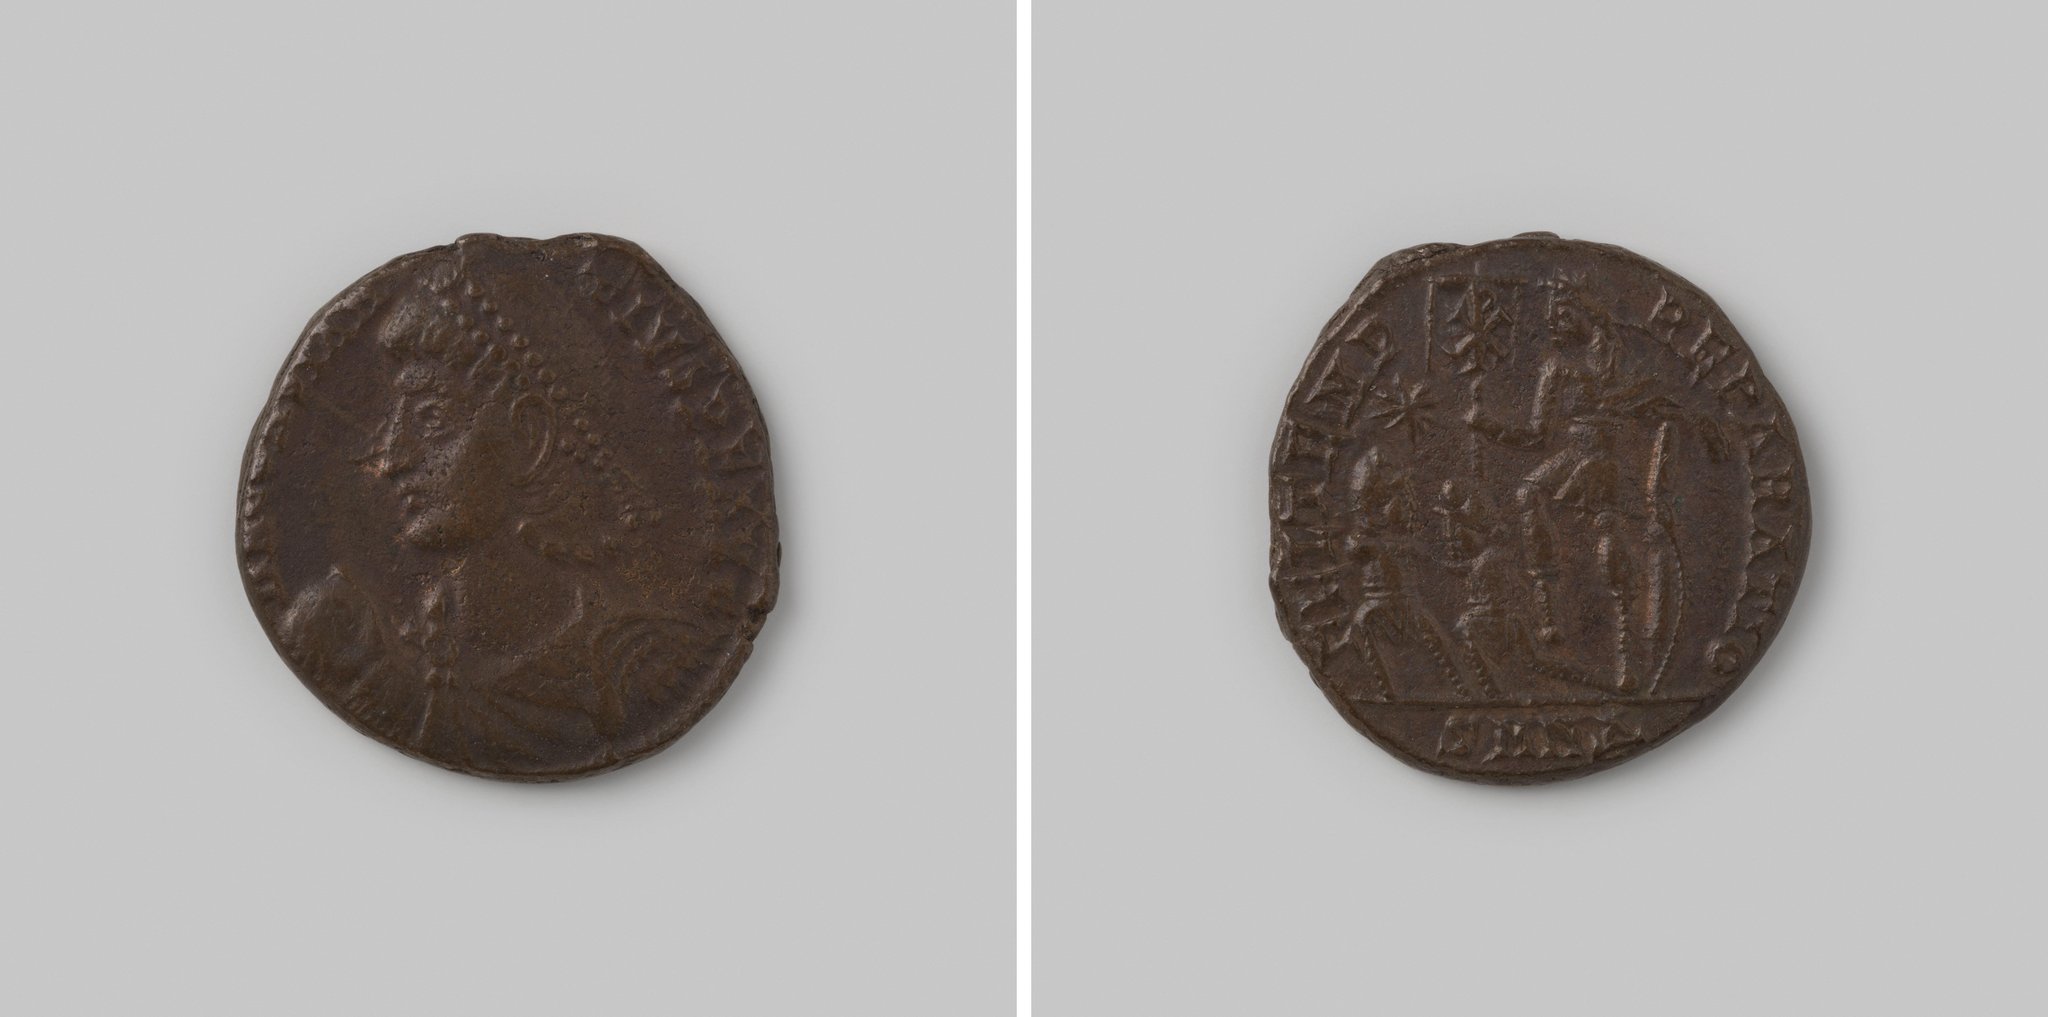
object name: ae2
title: Midden brons uit het Romeinse Keizerrijk van Constantius II, 336-361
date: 336-361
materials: bronze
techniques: striking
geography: nicomedia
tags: keizer, constantius ii (keizer van het romeinse rijk)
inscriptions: inscription: ‘SMN∆’, circumscription: ‘FEL TEMP REPARATIO’, circumscription: ‘D N CONSTAN - TIVS P F AVG’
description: keerzijde: de keizer, staand met harnas en toga, Chi-Rho vaandel in rechterhand en linkerhand rustend op schild, links van hem twee geknielde krijgsgevangenen, tekst in afsnede